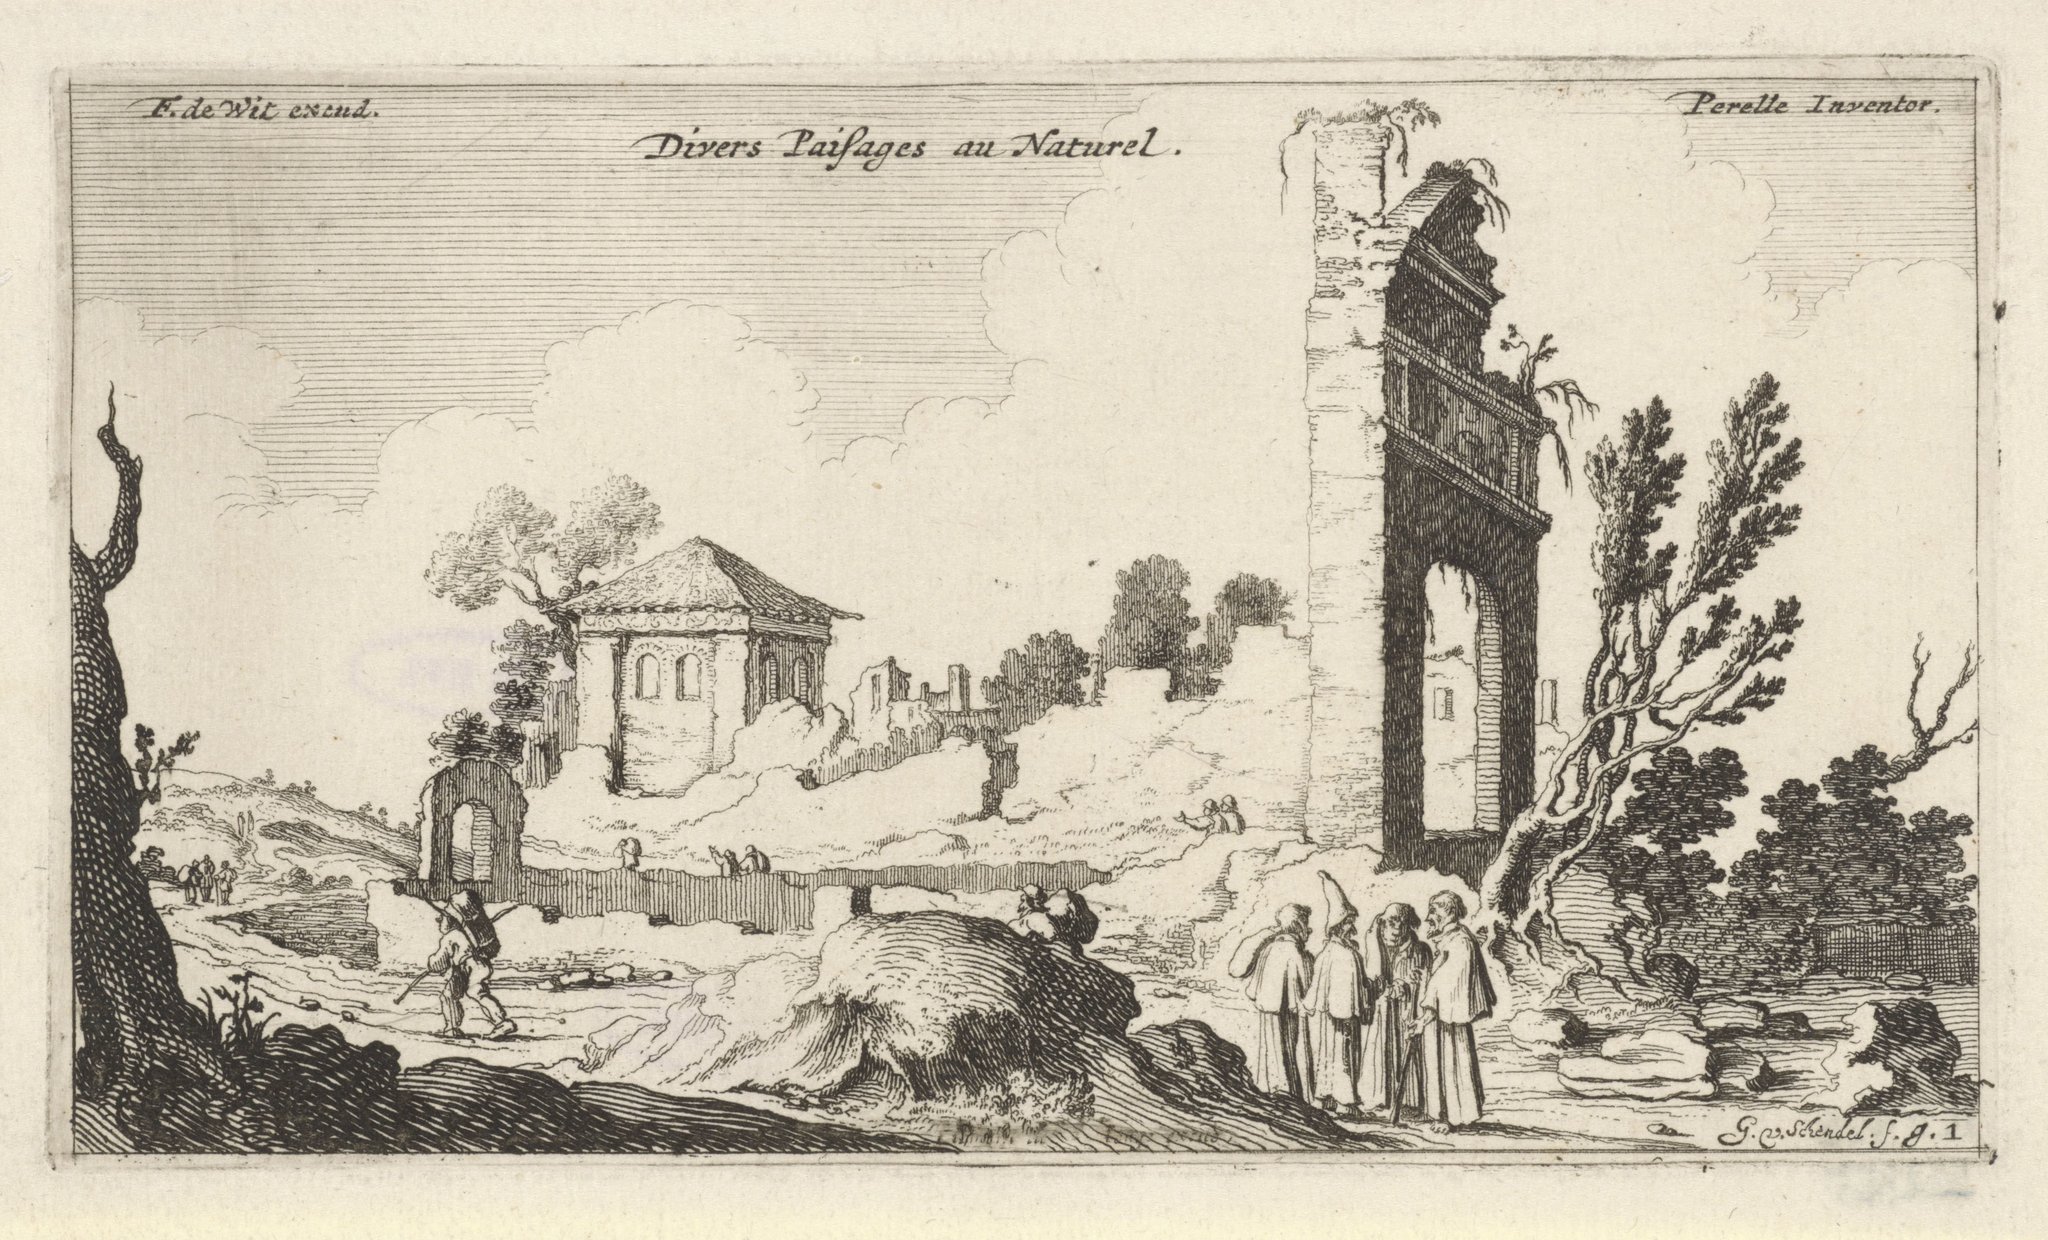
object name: print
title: Heuvelland met een vervallen muur en een poort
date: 1640-1706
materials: paper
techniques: etching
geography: amsterdam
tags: landscape with ruins, monk(s), friar(s)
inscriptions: collector's mark: Lugt 2165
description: Glooiend landschap met een vervallen muur en een poort in een boog. Op de voorgrond vier monniken en een landweg met een wandelaar. De prent maakt deel uit van een serie van twaalf landschappen.